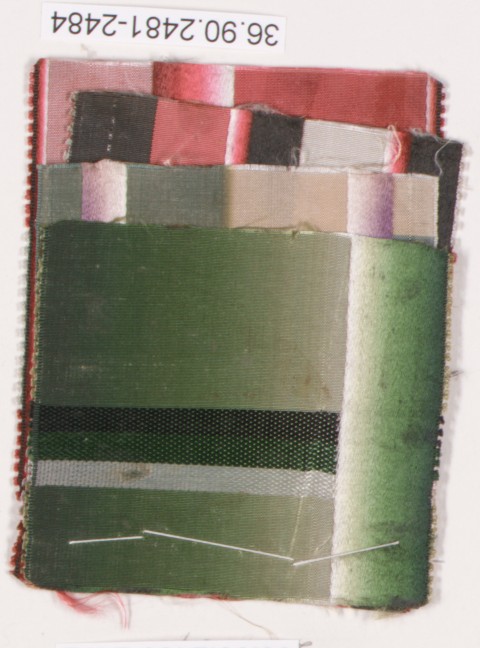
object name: ribbon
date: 1801-1900